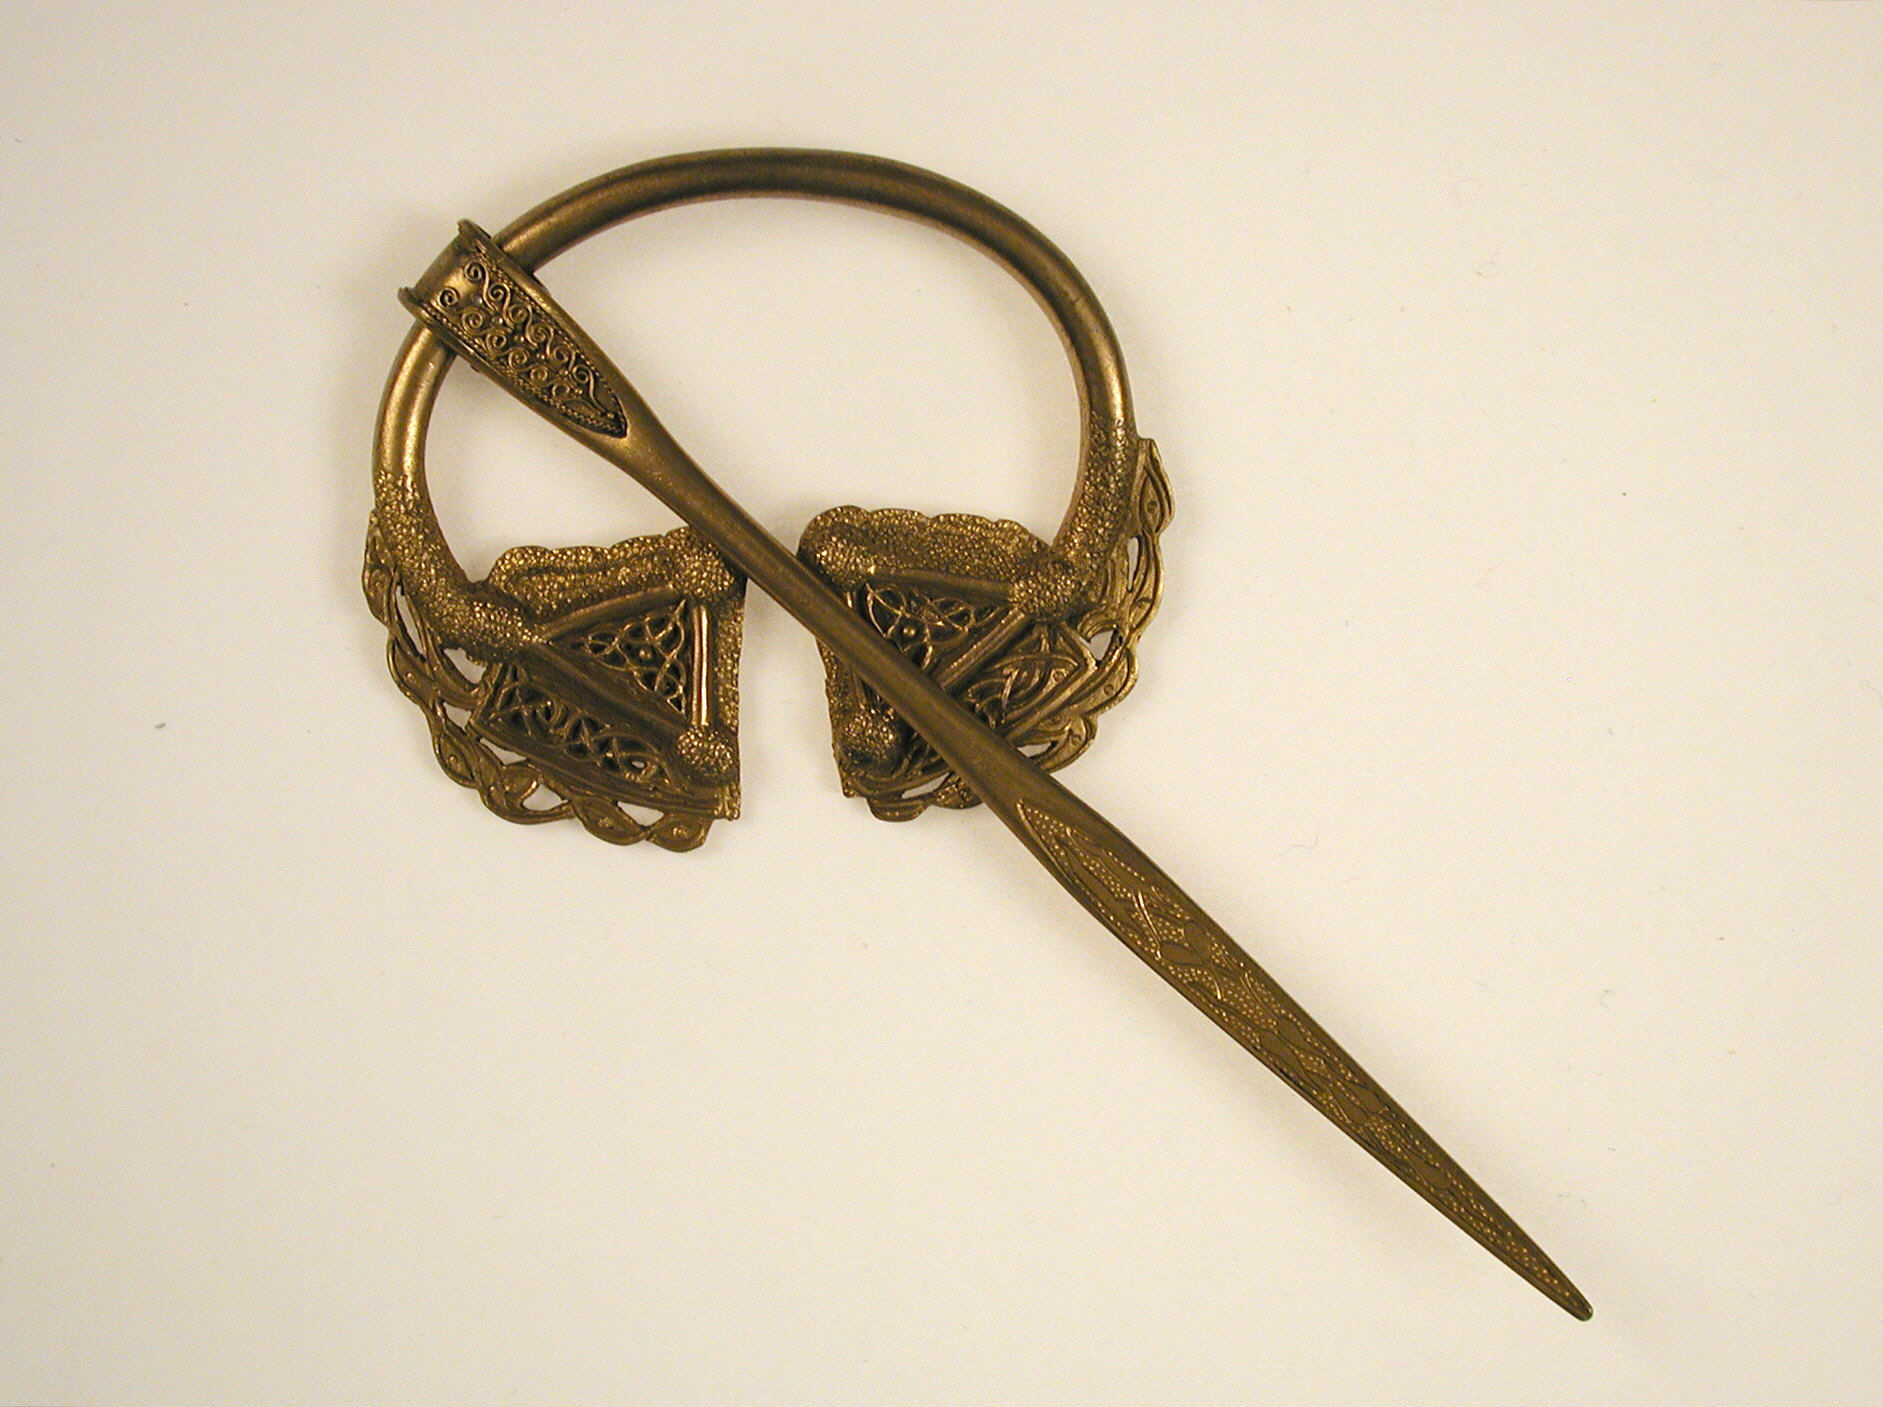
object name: brooch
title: Dalriada Brooch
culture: irish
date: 1901-1933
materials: gold